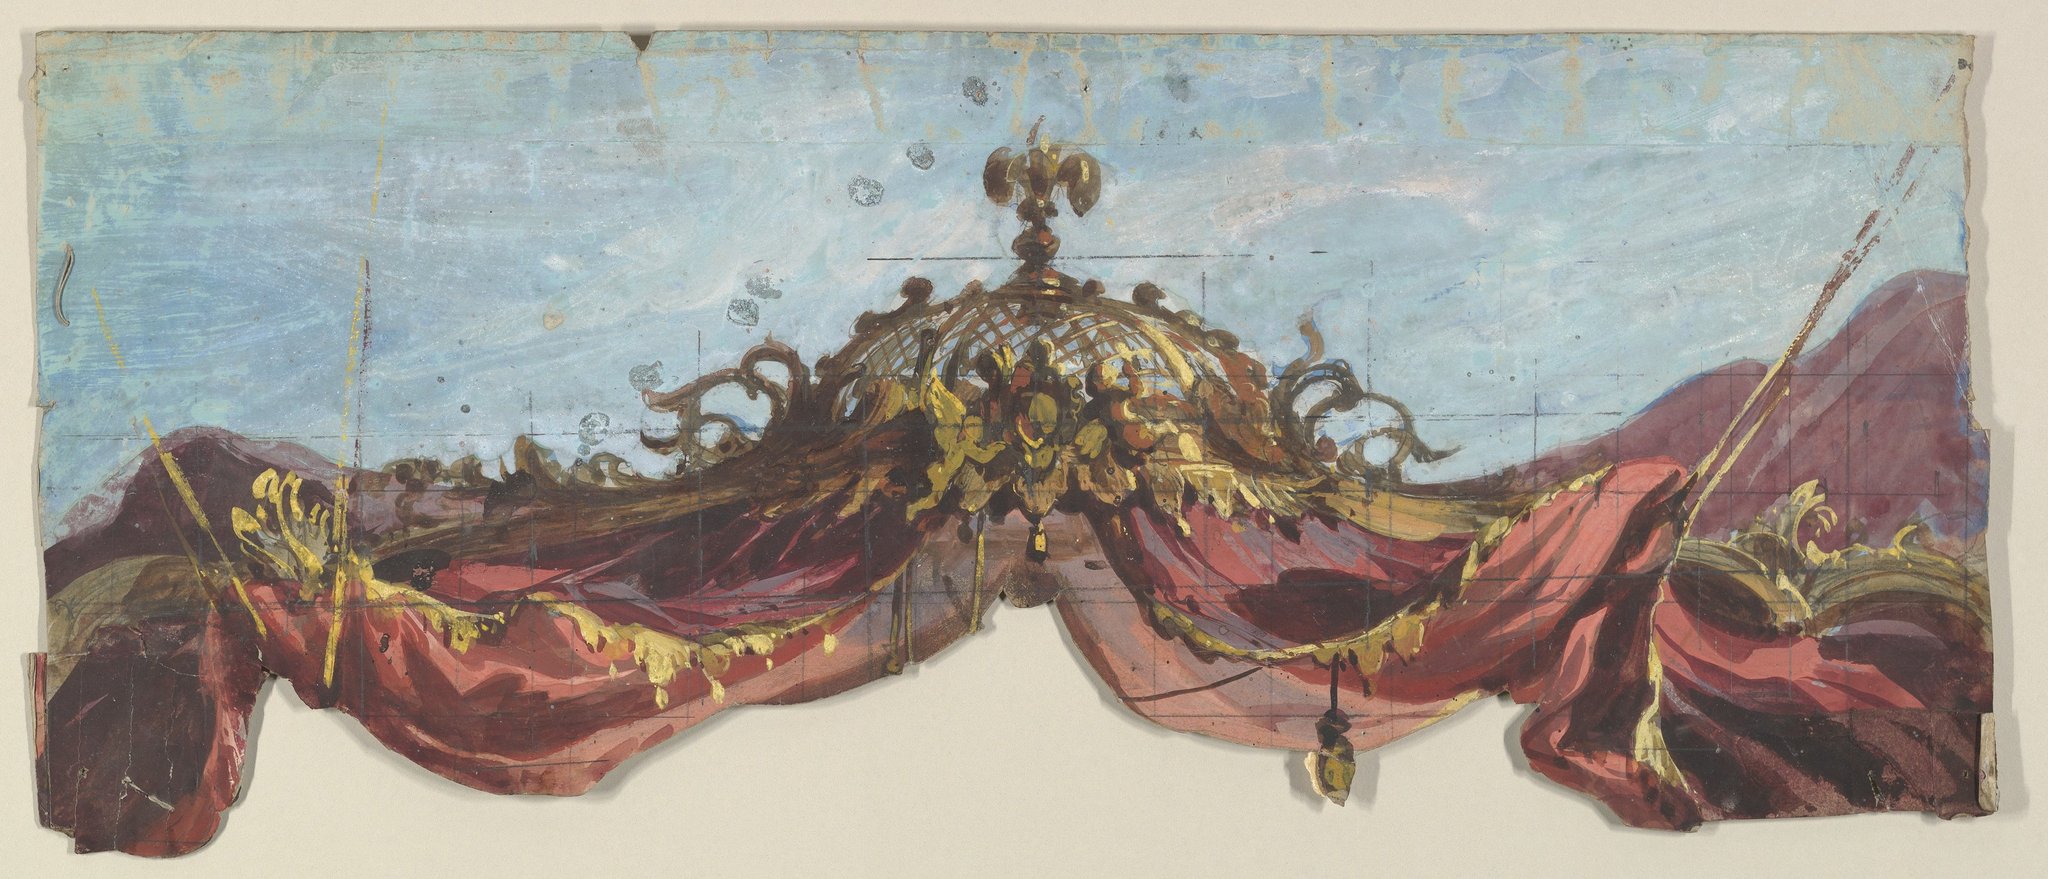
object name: drawing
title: Design for a Stage Set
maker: eugène cicéri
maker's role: artist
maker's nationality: french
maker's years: 1813-1890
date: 1830-1890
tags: stage design